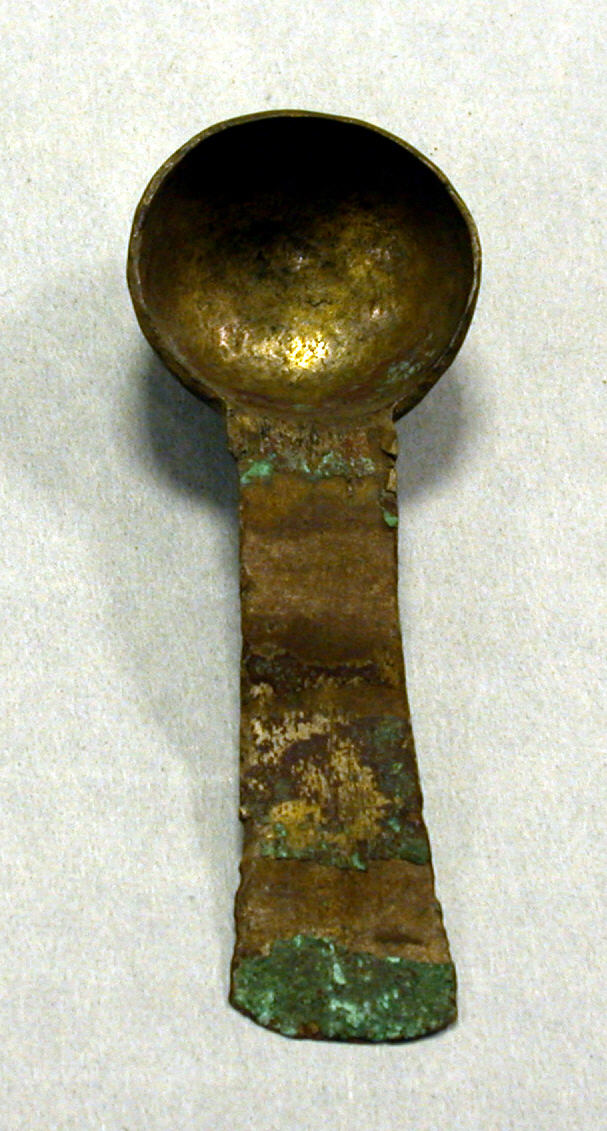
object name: spoon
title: Hammered Silver Spoon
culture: peruvian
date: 701-1566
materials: gilt, silver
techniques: hammering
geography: peru